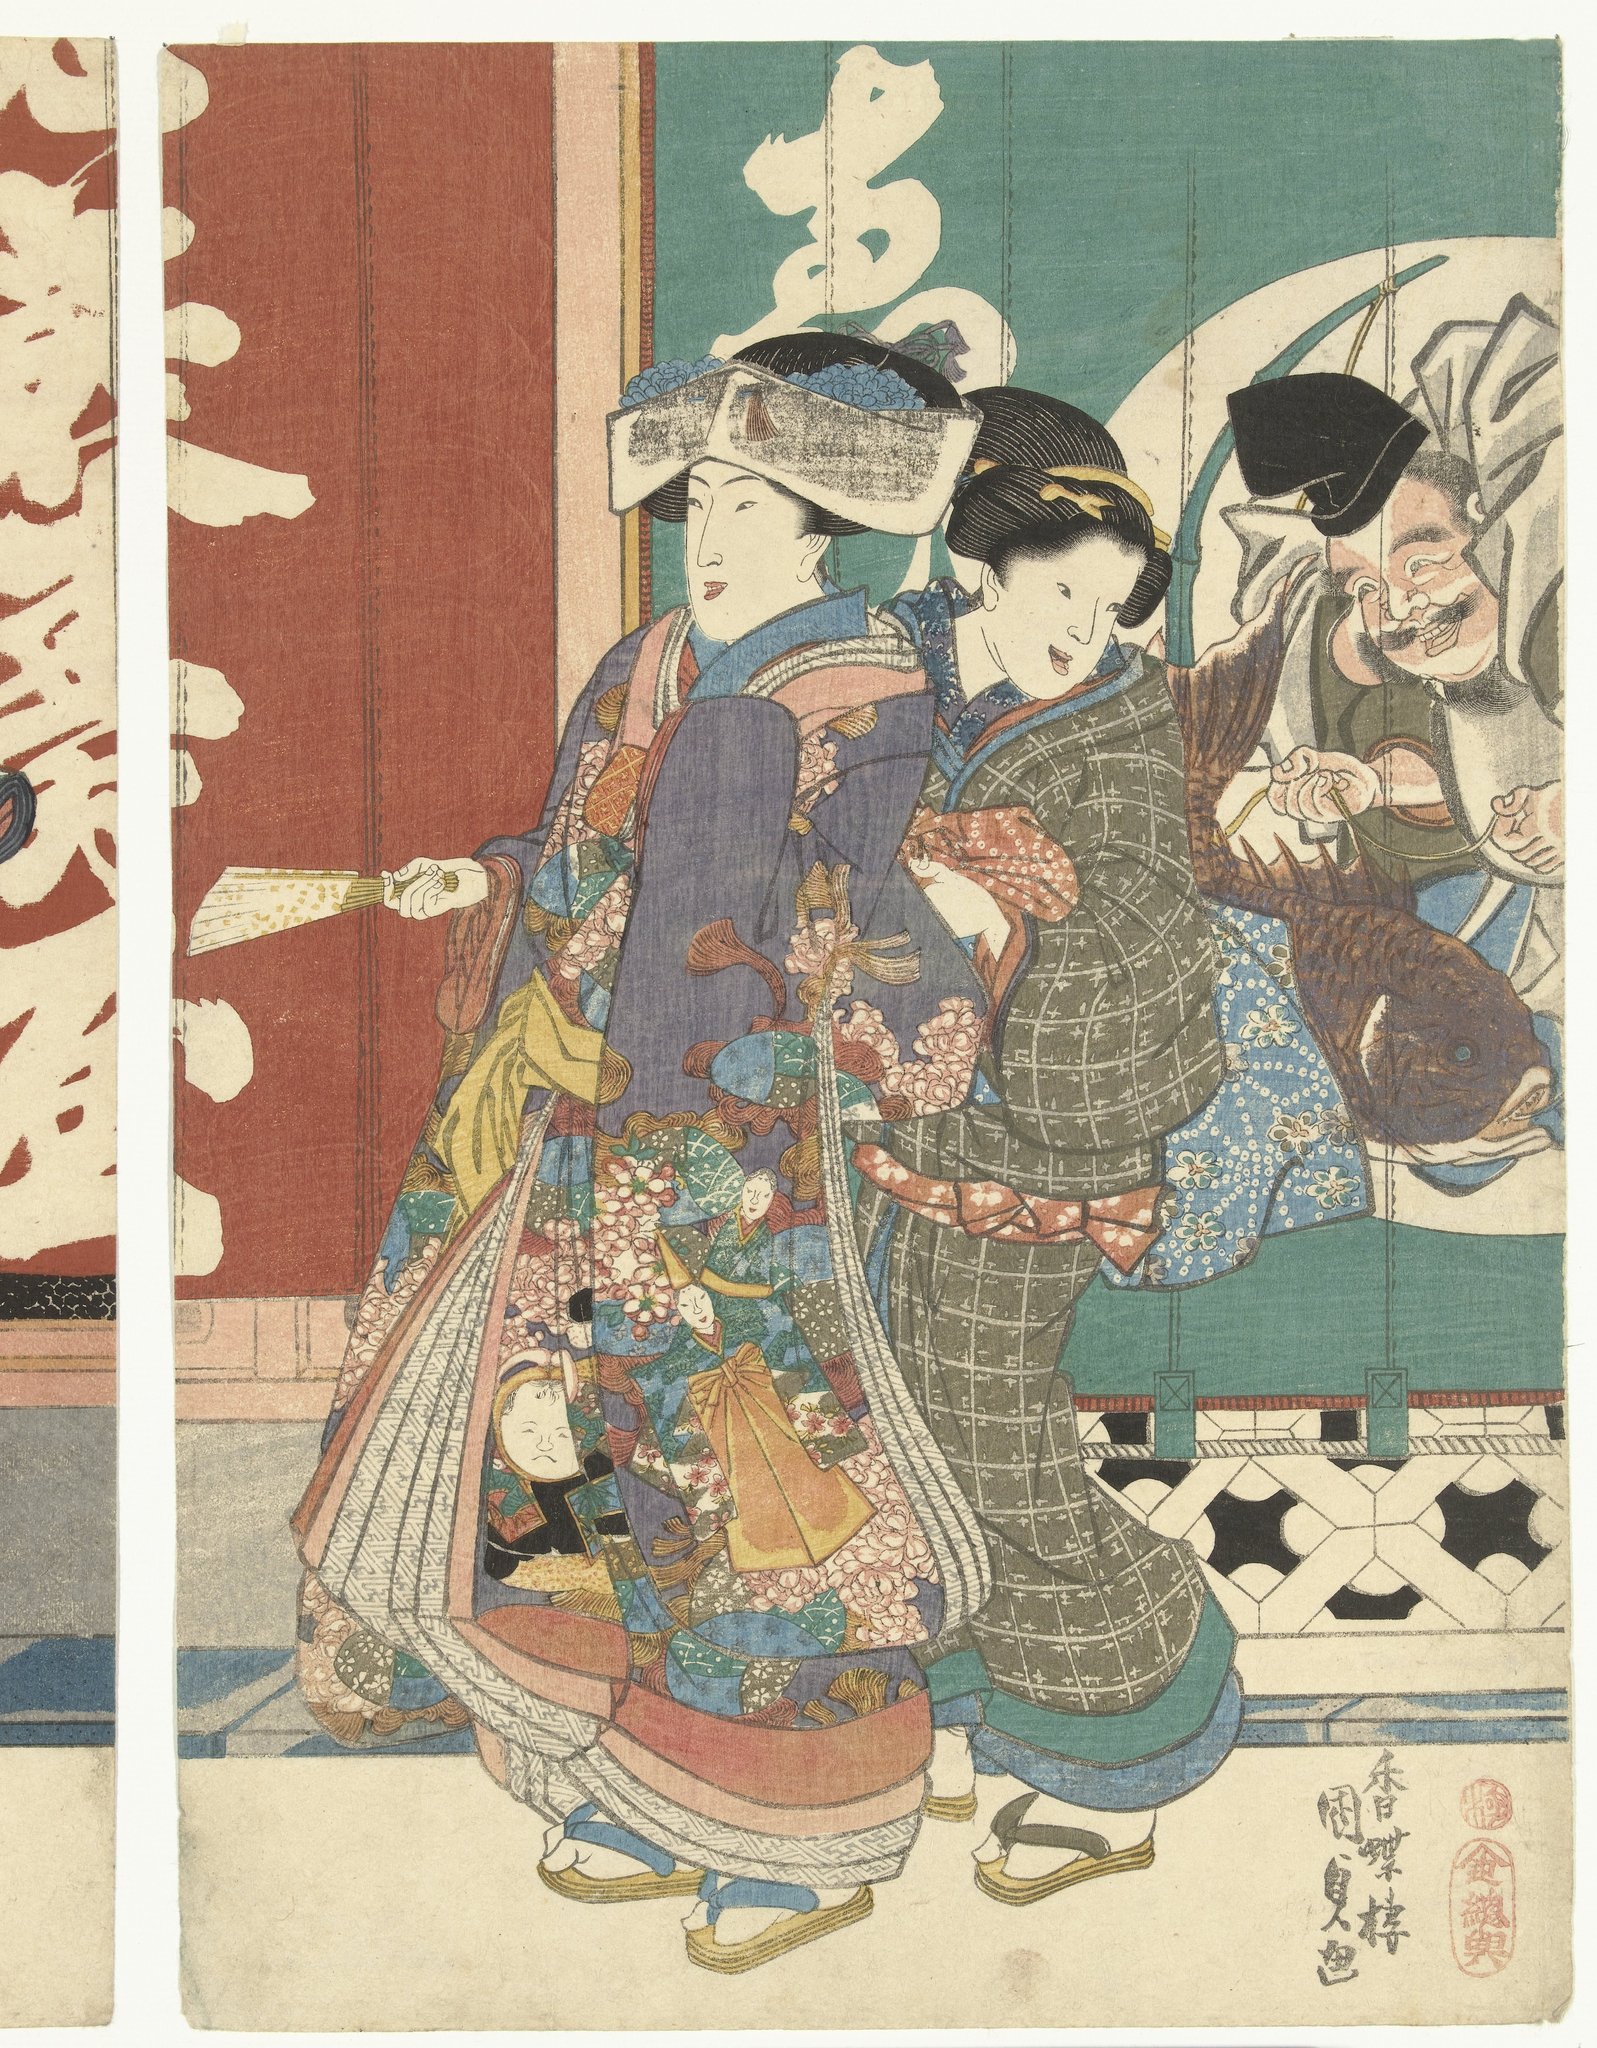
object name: print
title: Vrouwen bij de Ebisuya winkel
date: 1842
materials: paper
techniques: woodcut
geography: japan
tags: head-gear, fan, adult woman (+ two persons)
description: Twee vrouwen, de voorste met witte bruidshoed op en waaier in rechter hand, staand bij groen en rode winkelwand waarop gedeeltelijk een rond embleem zichtbaar met de geluksgod Ebisu met vis en hengel.